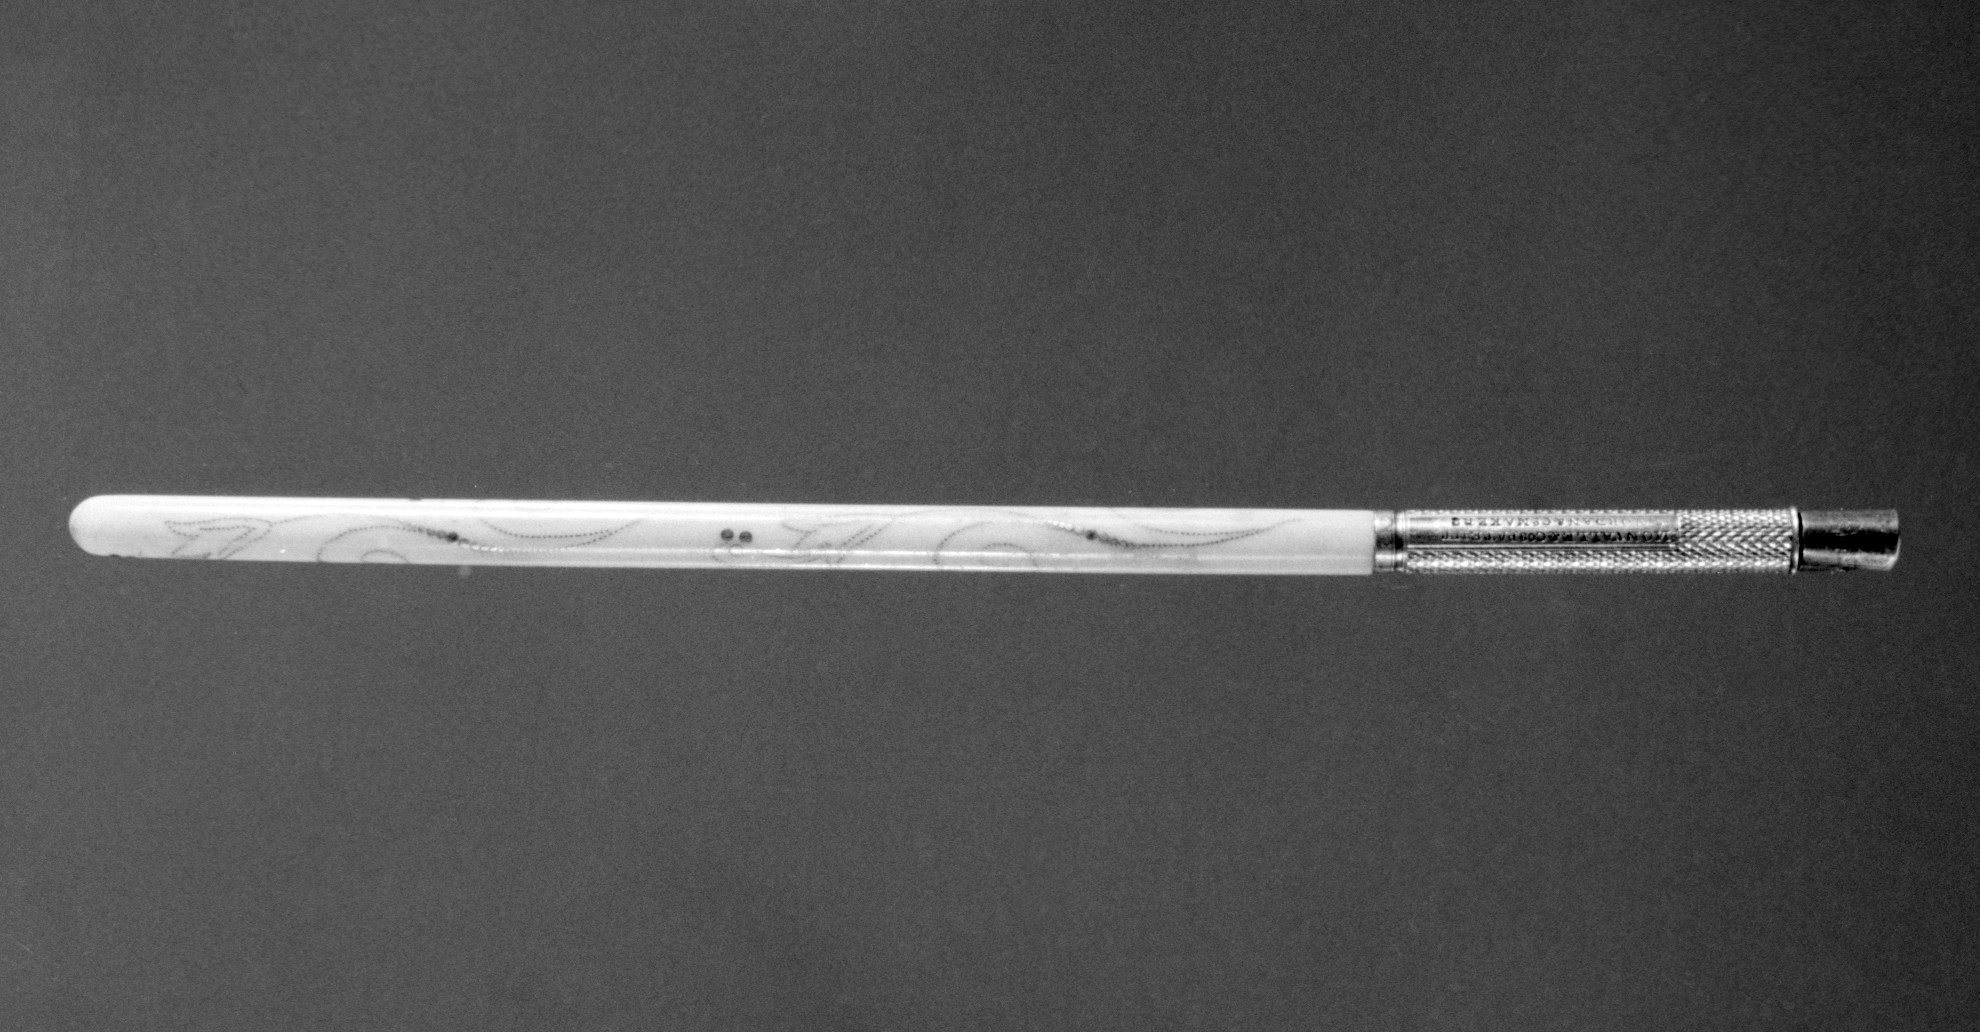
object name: pen handle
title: Pen handle (part of a set)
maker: s. mordan & co., england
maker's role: maker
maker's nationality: british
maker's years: 1823-1898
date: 1848-1849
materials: ivory, silver